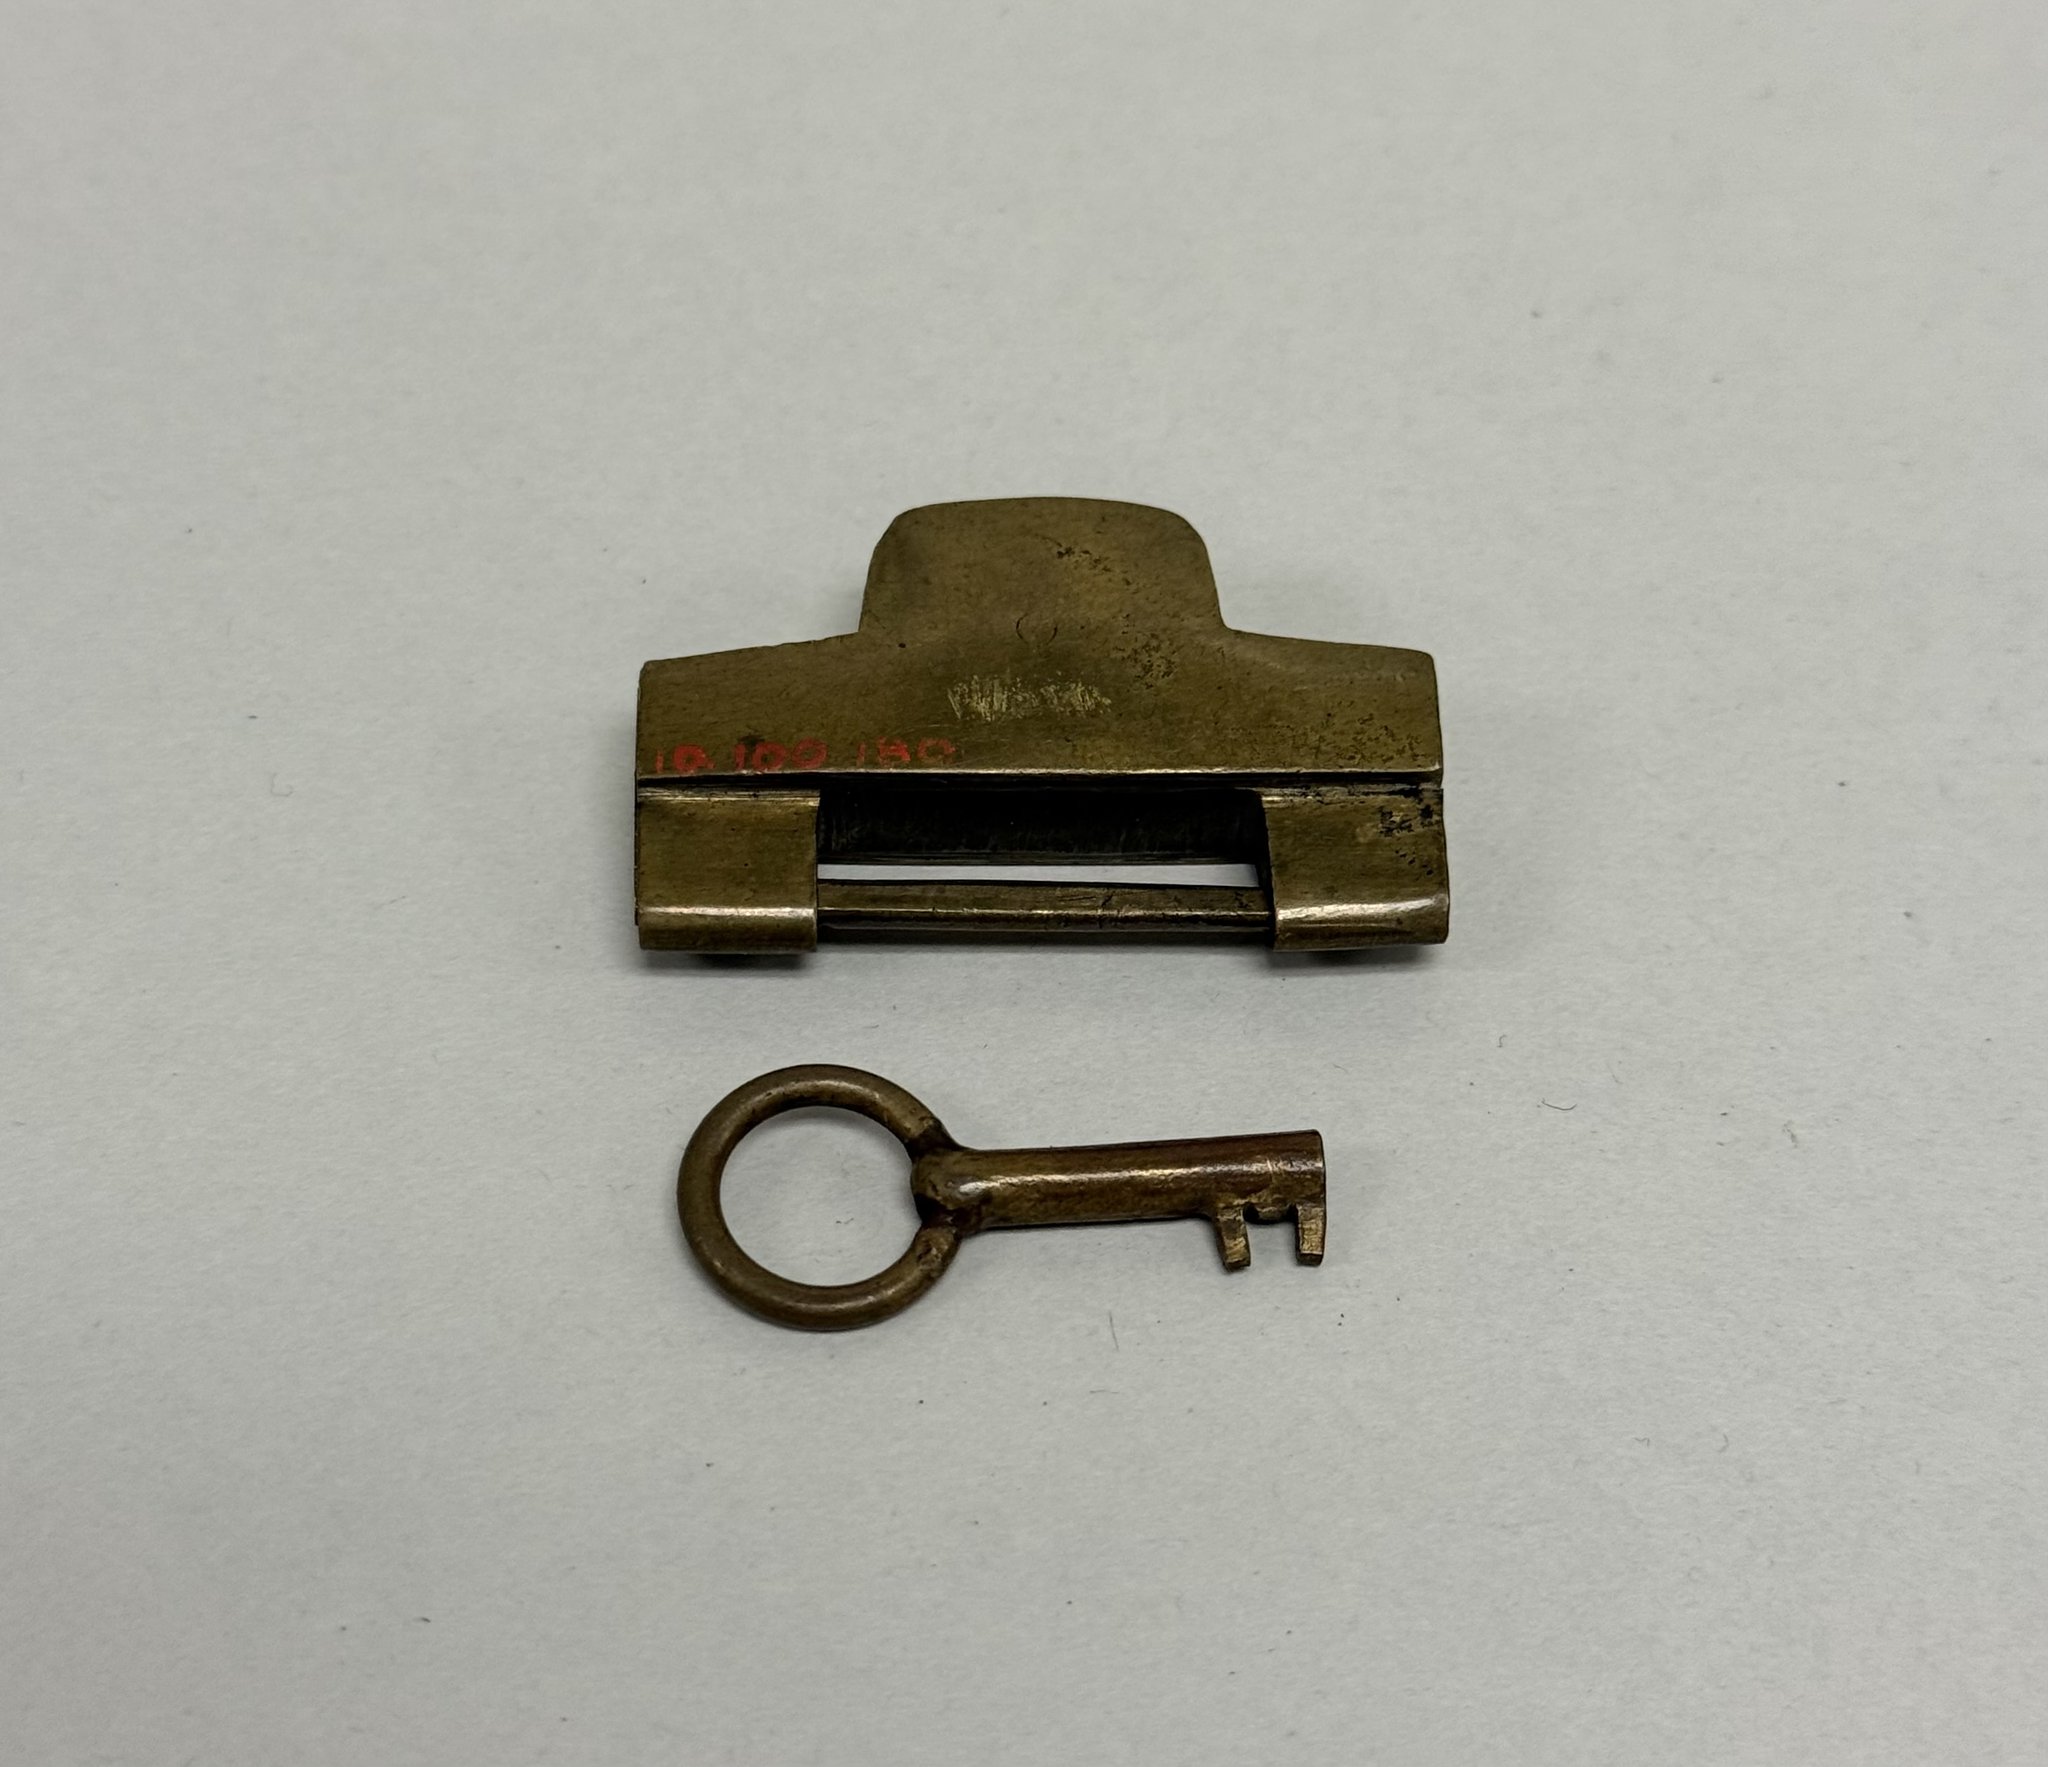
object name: lock and key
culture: japanese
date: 1801-1900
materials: brass